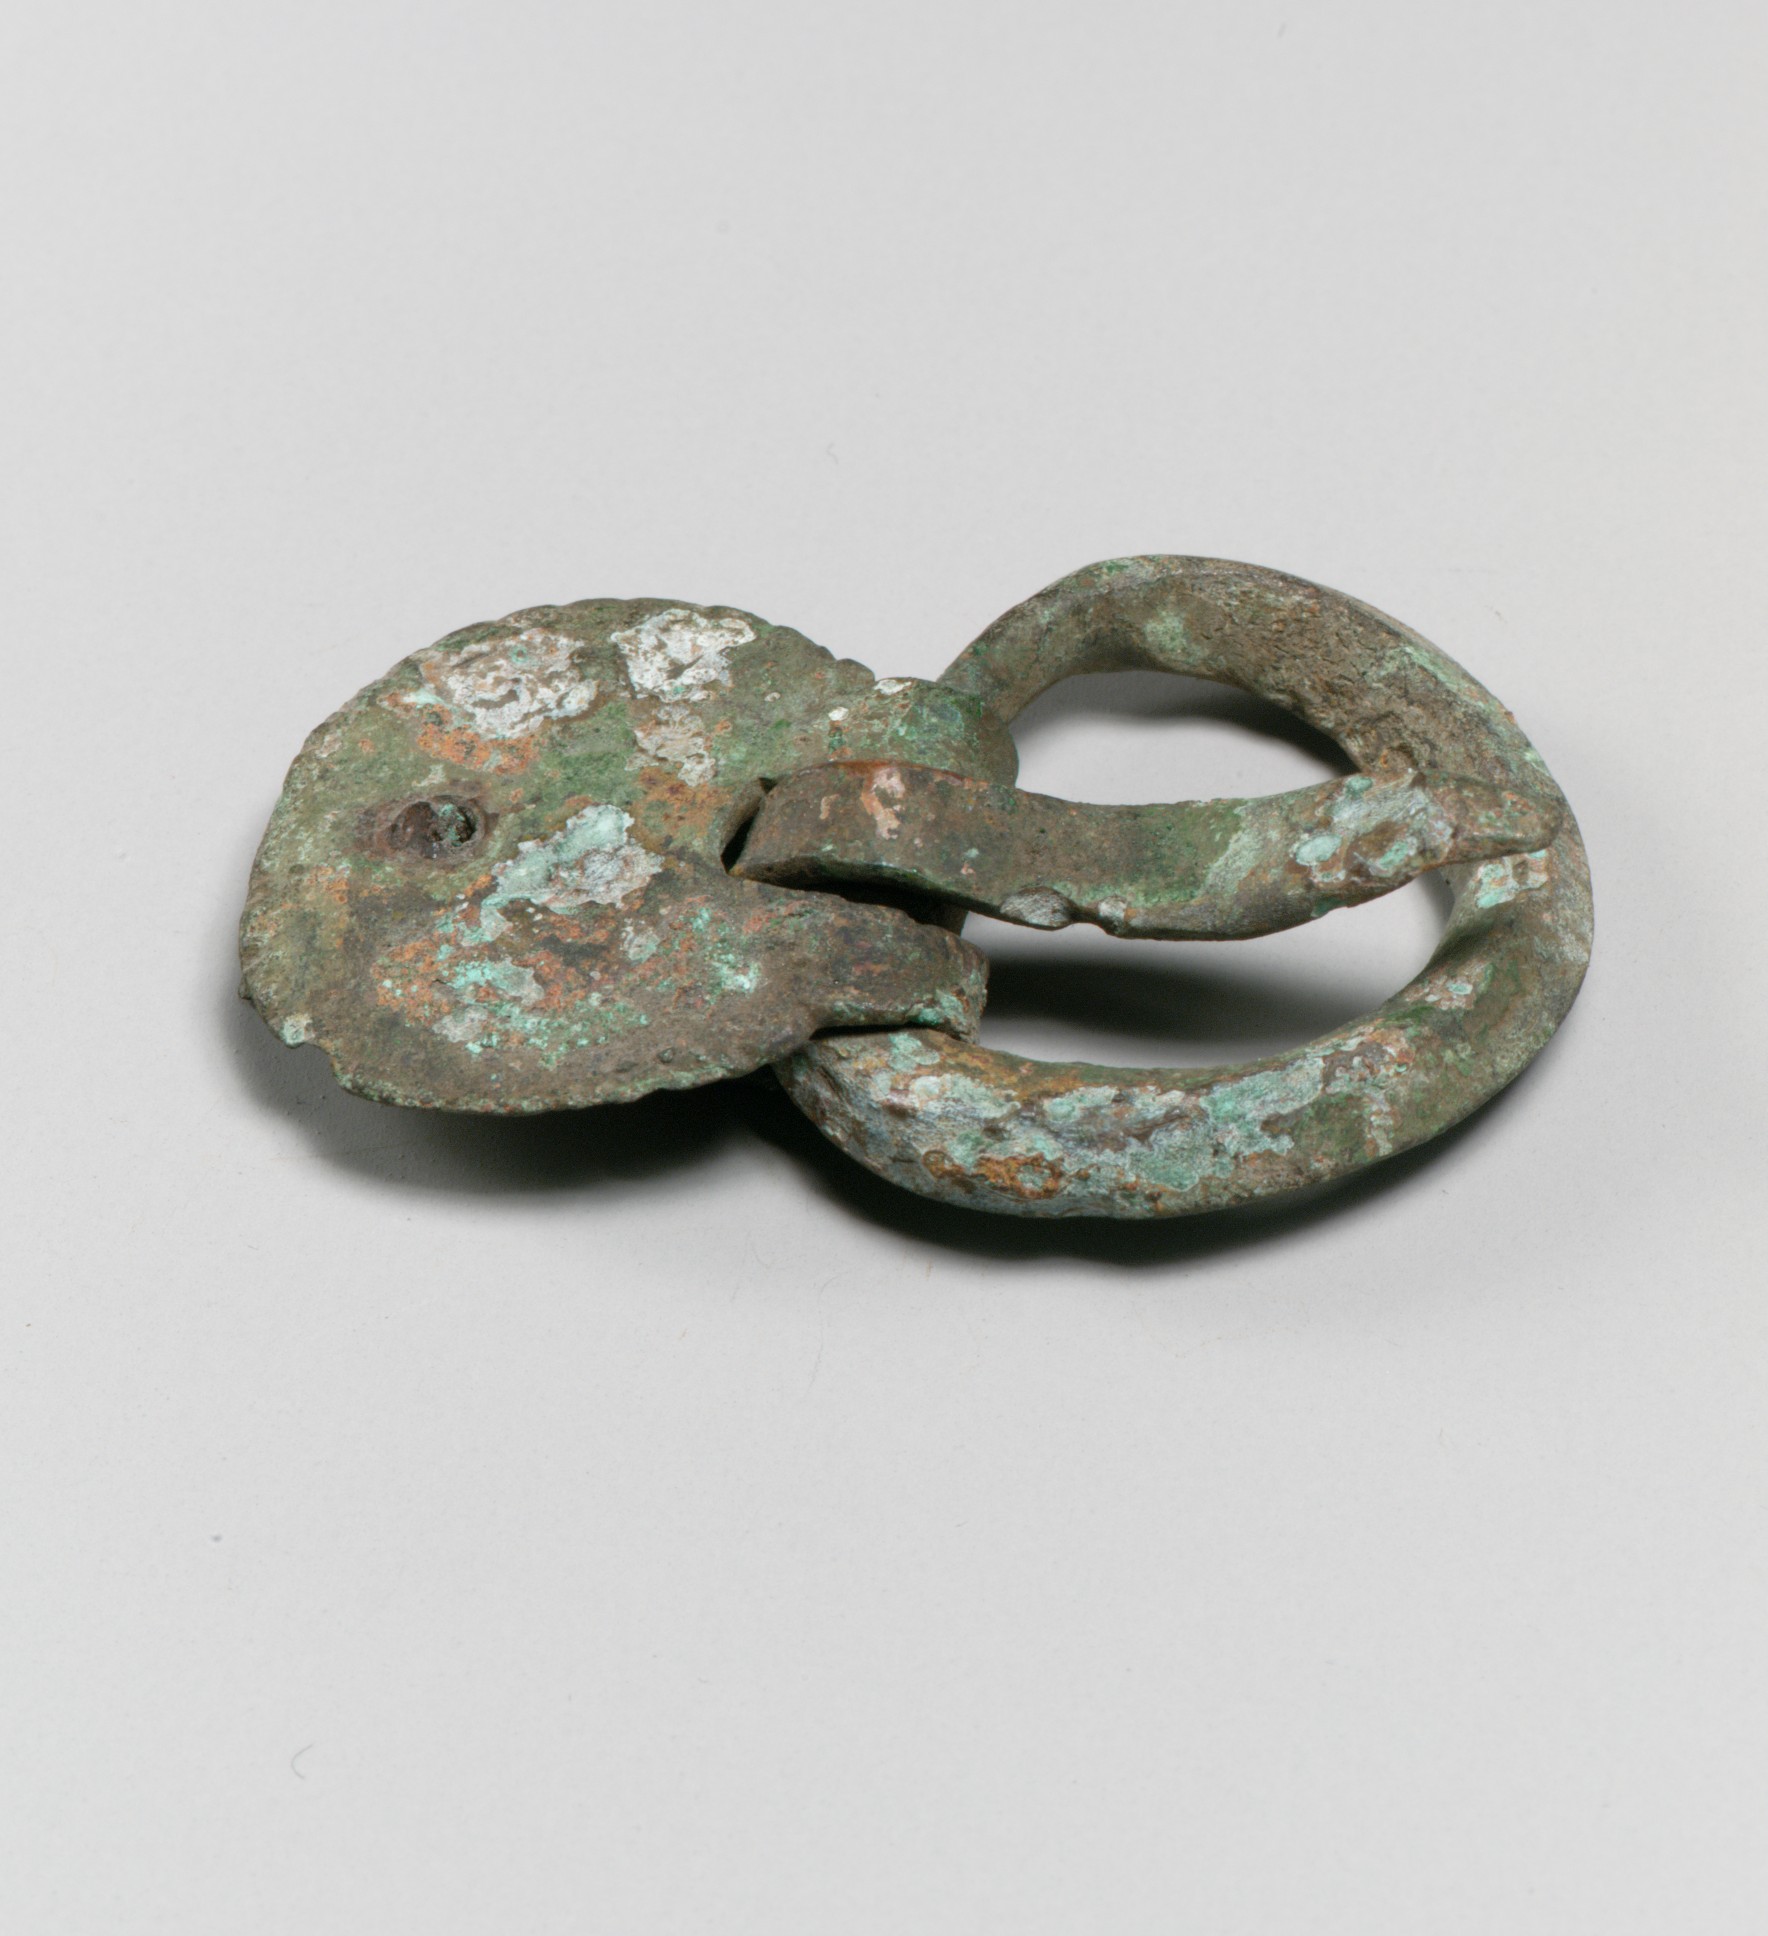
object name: buckle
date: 7000 BCE-330 CE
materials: bronze